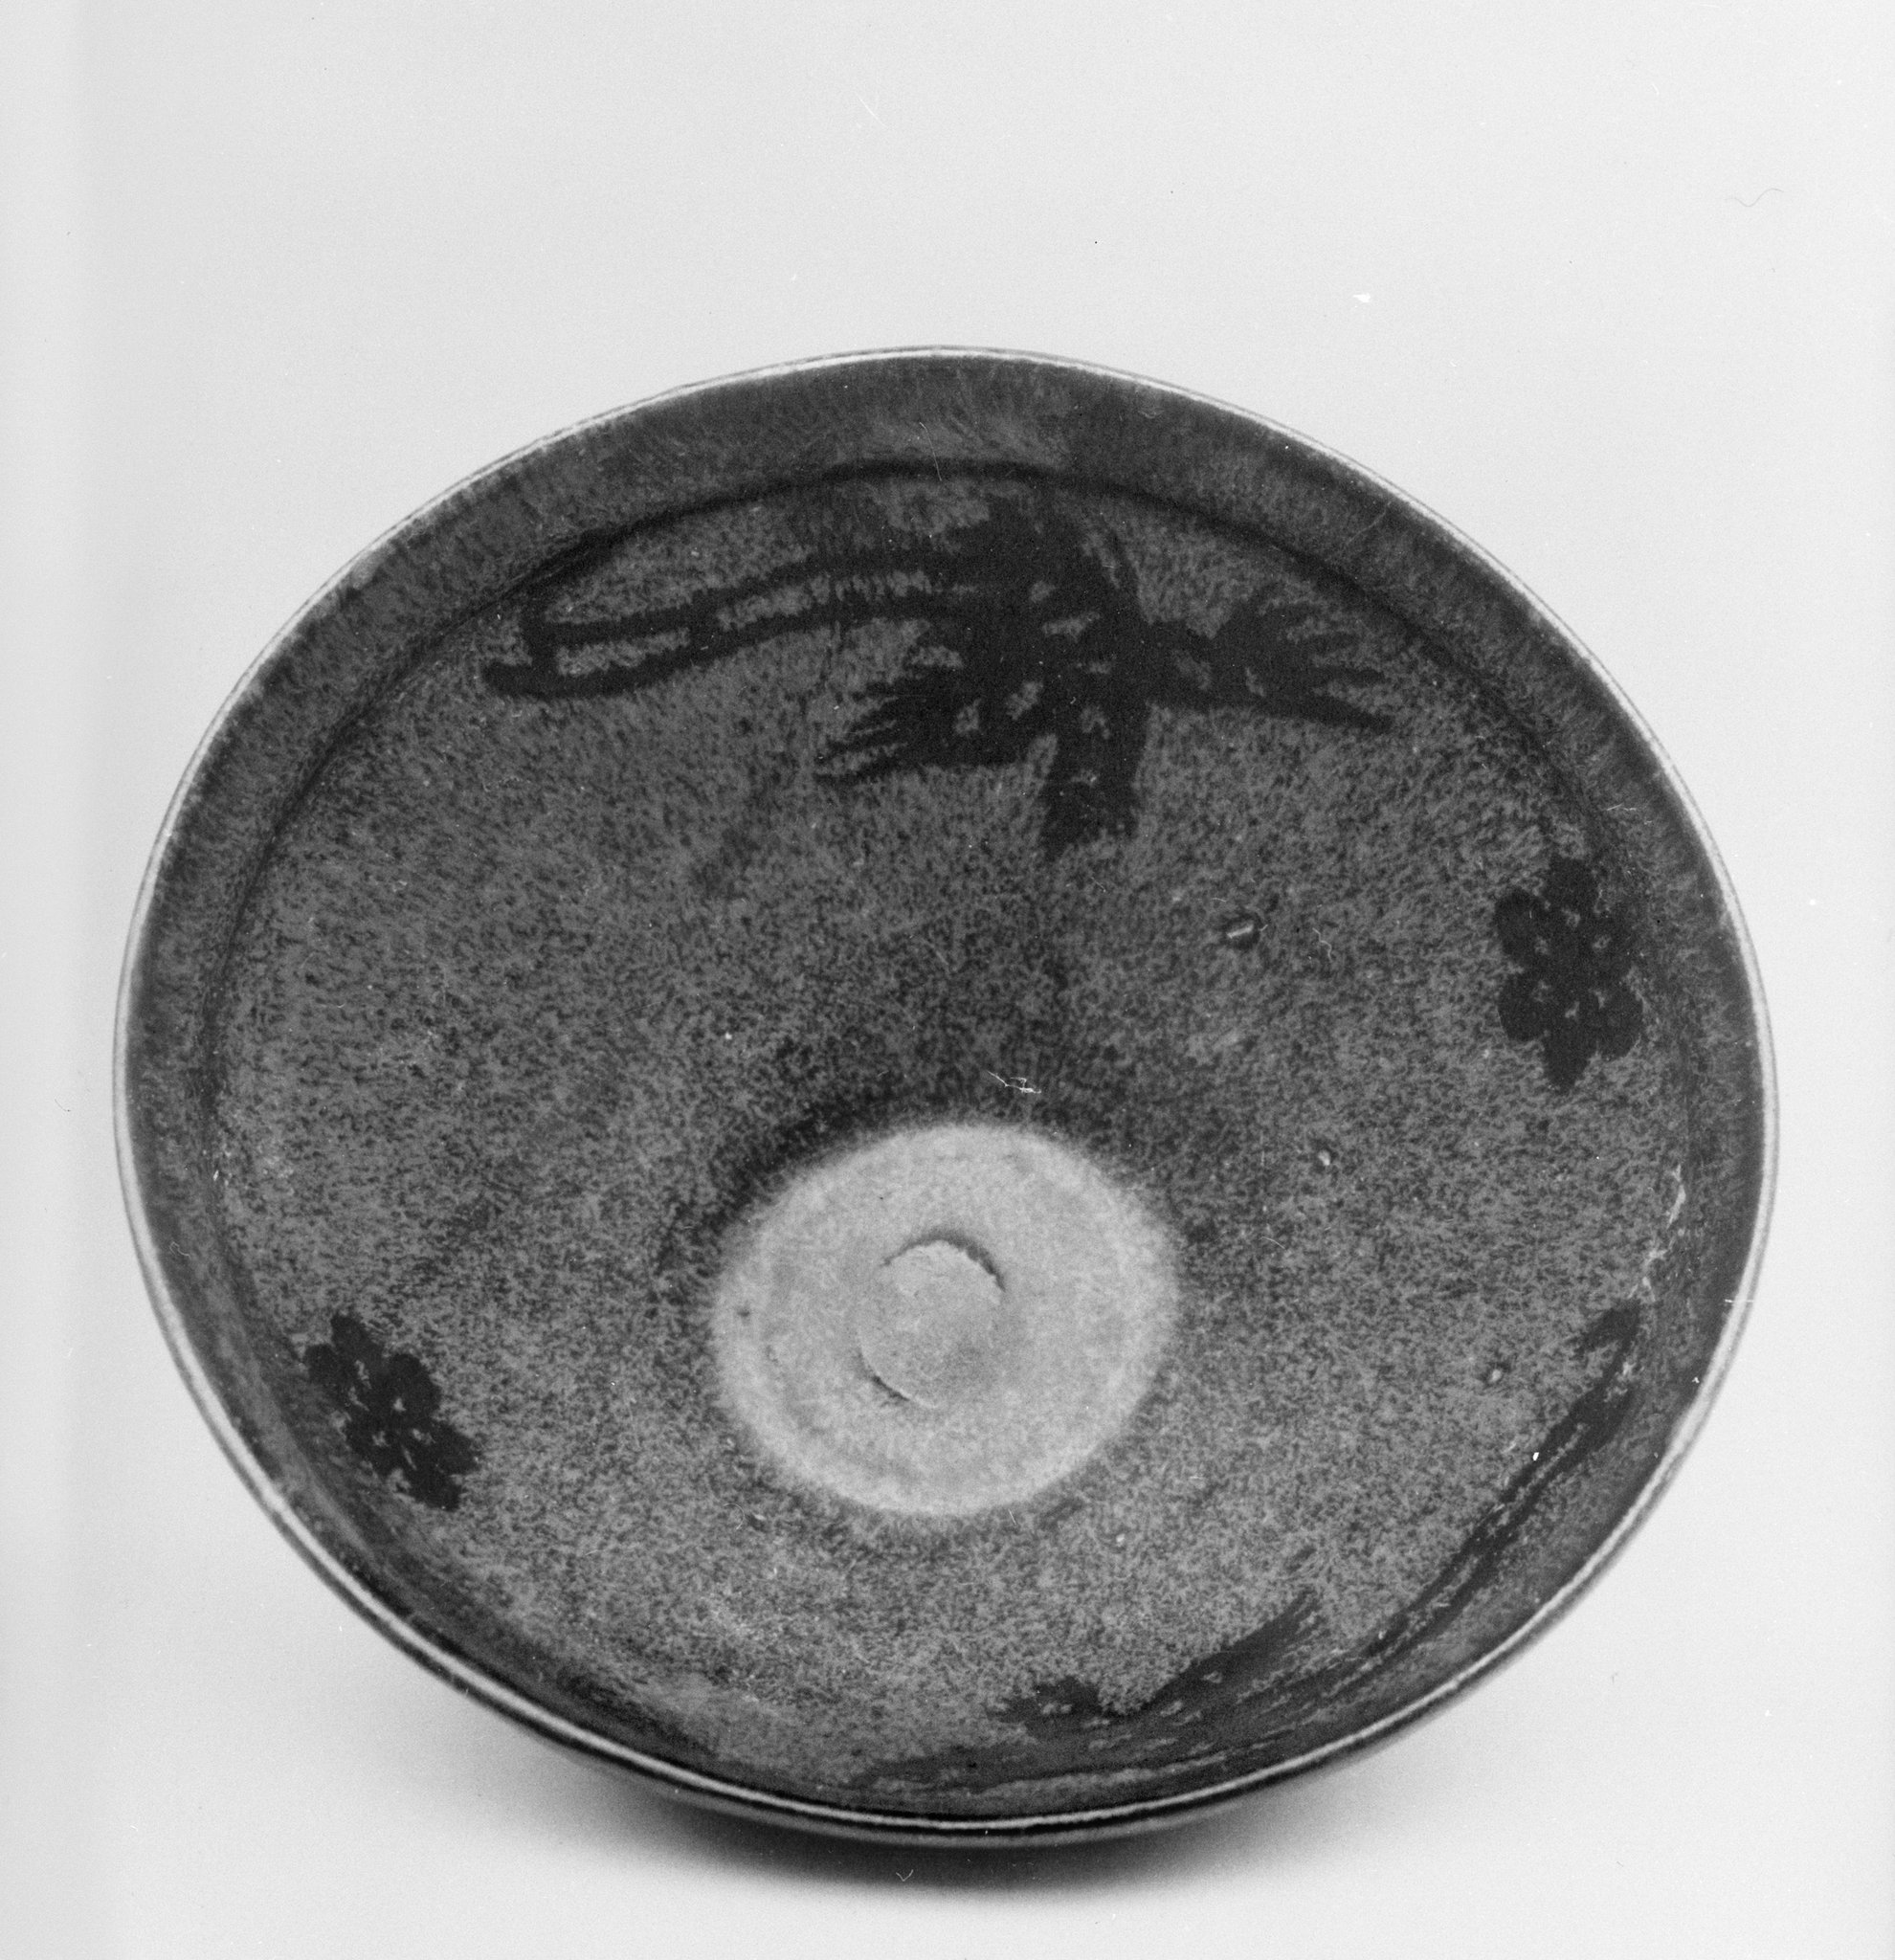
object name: bowl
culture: chinese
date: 960-1279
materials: pottery